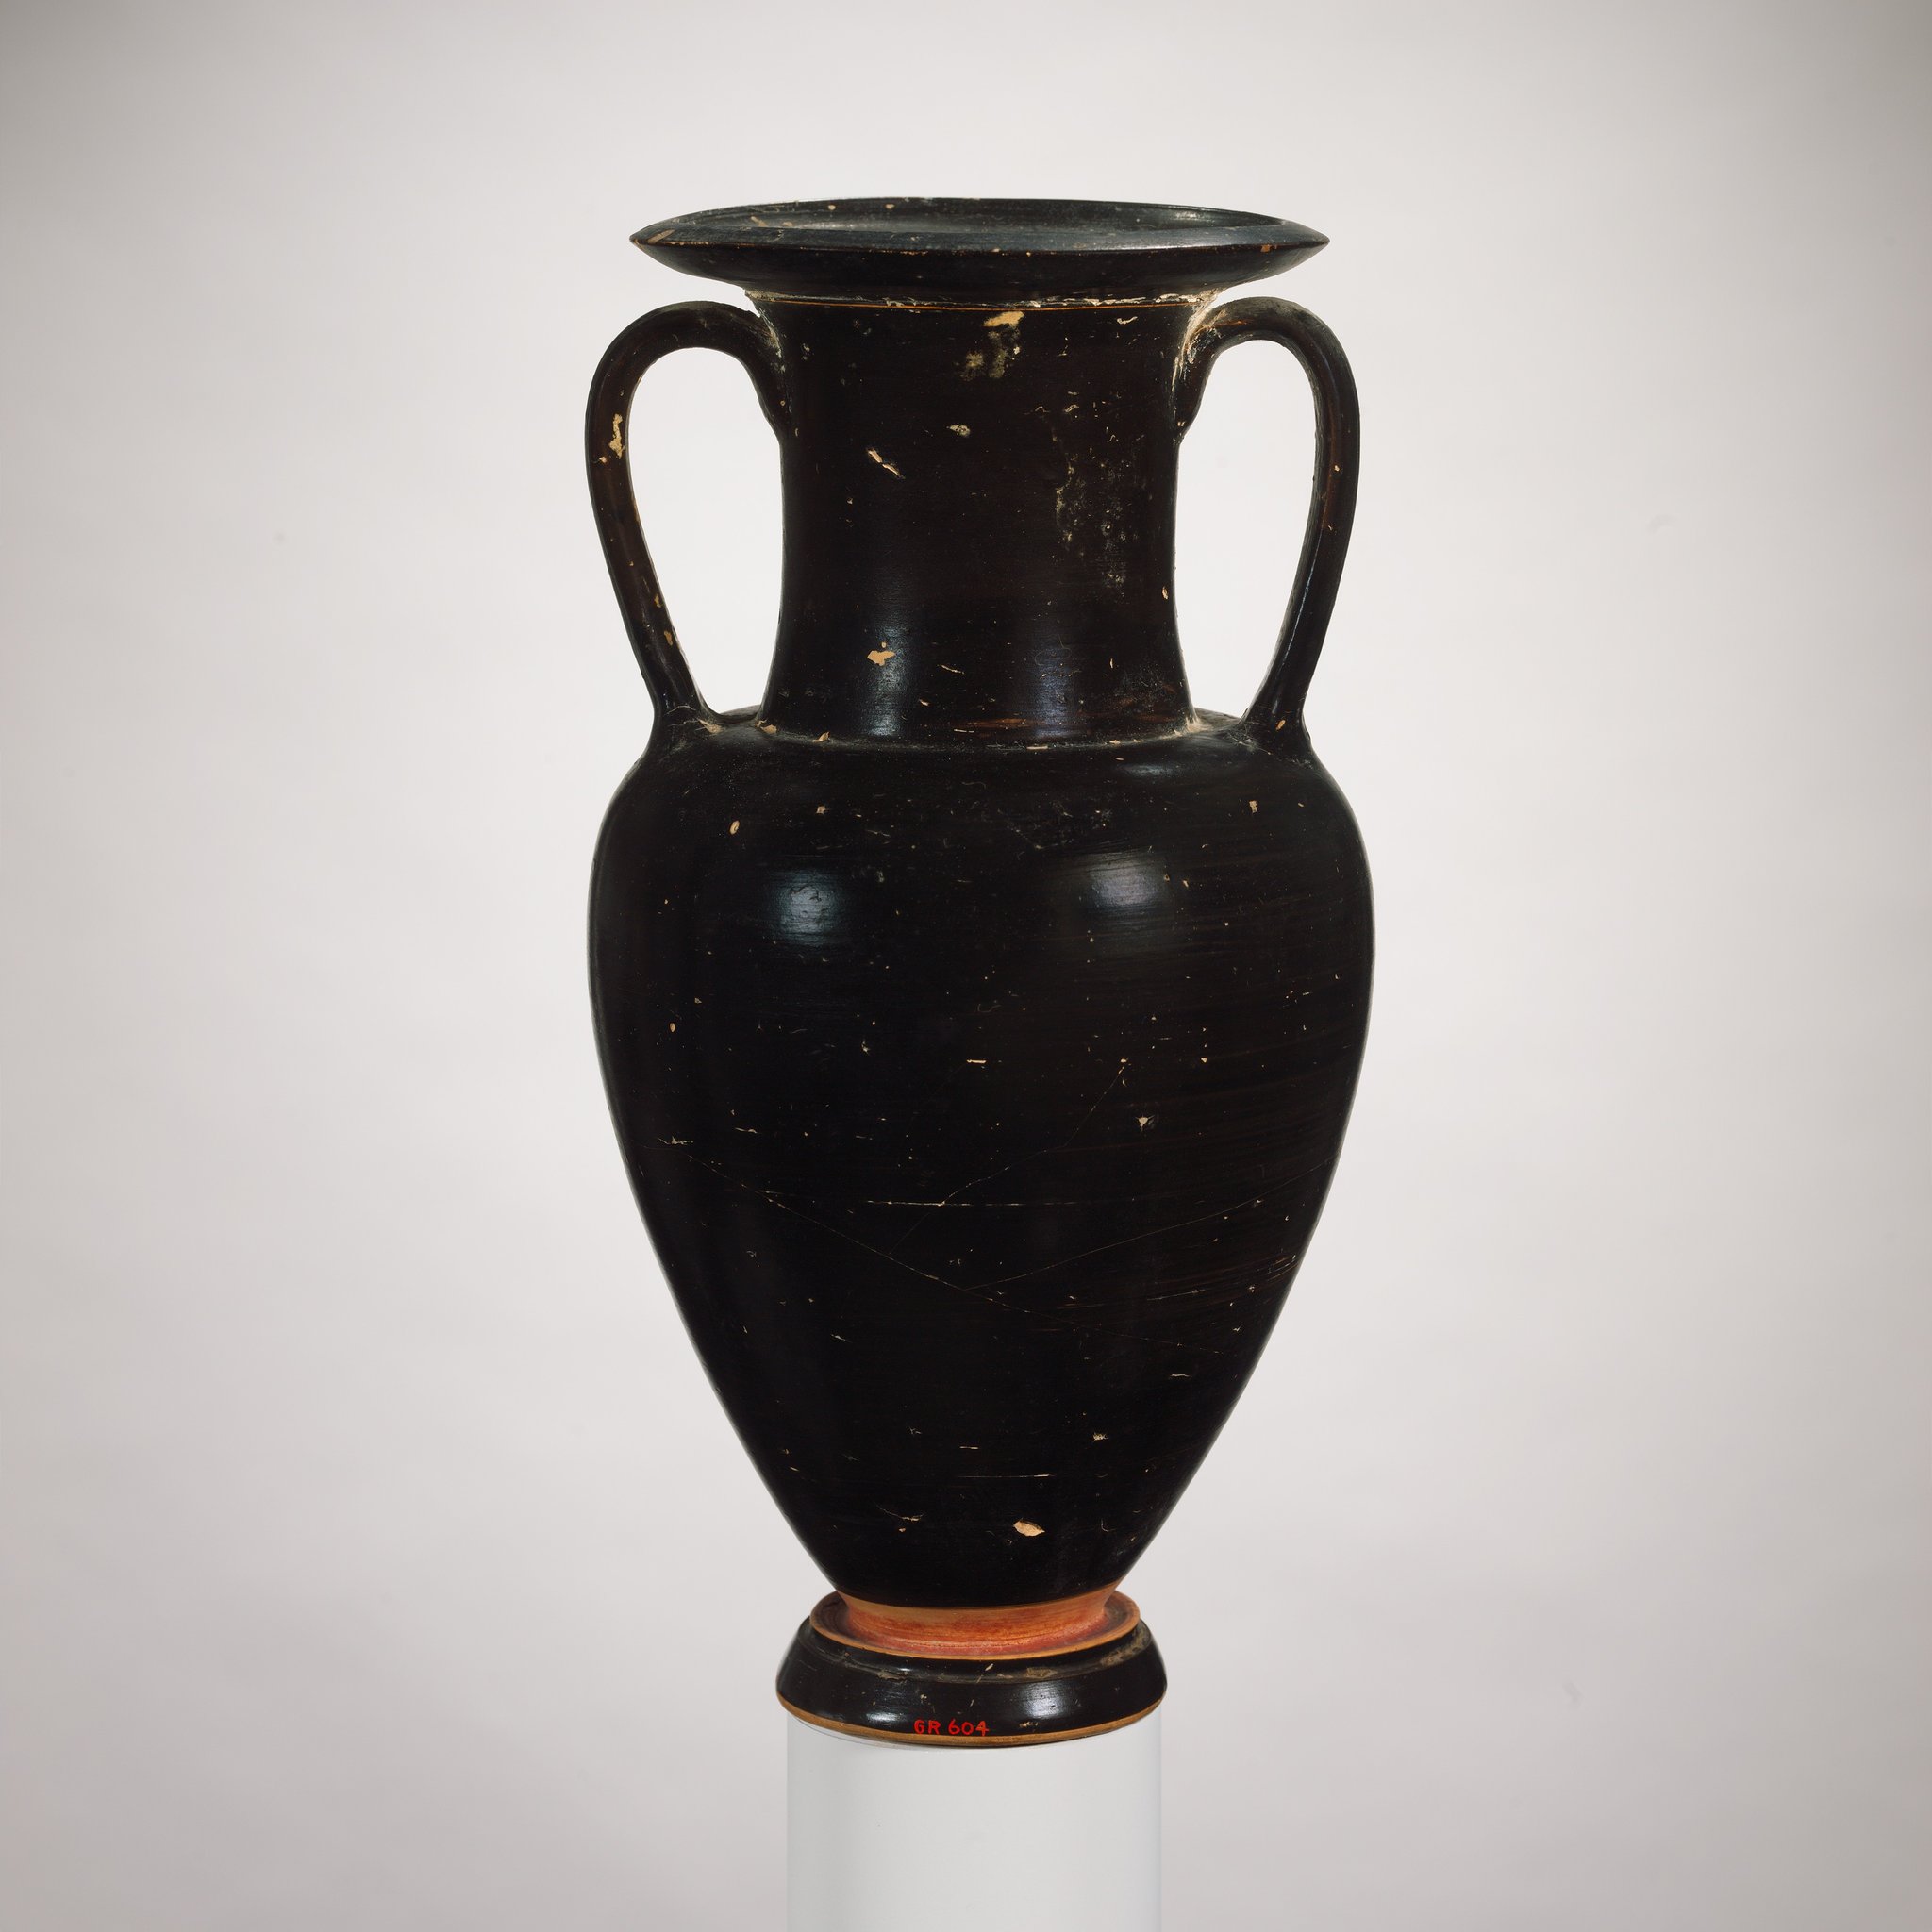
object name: neck amphora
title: Terracotta neck-amphora (jar)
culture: greek or south italian or campanian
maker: owl-pillar group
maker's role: artist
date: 434-401 BCE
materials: terracotta